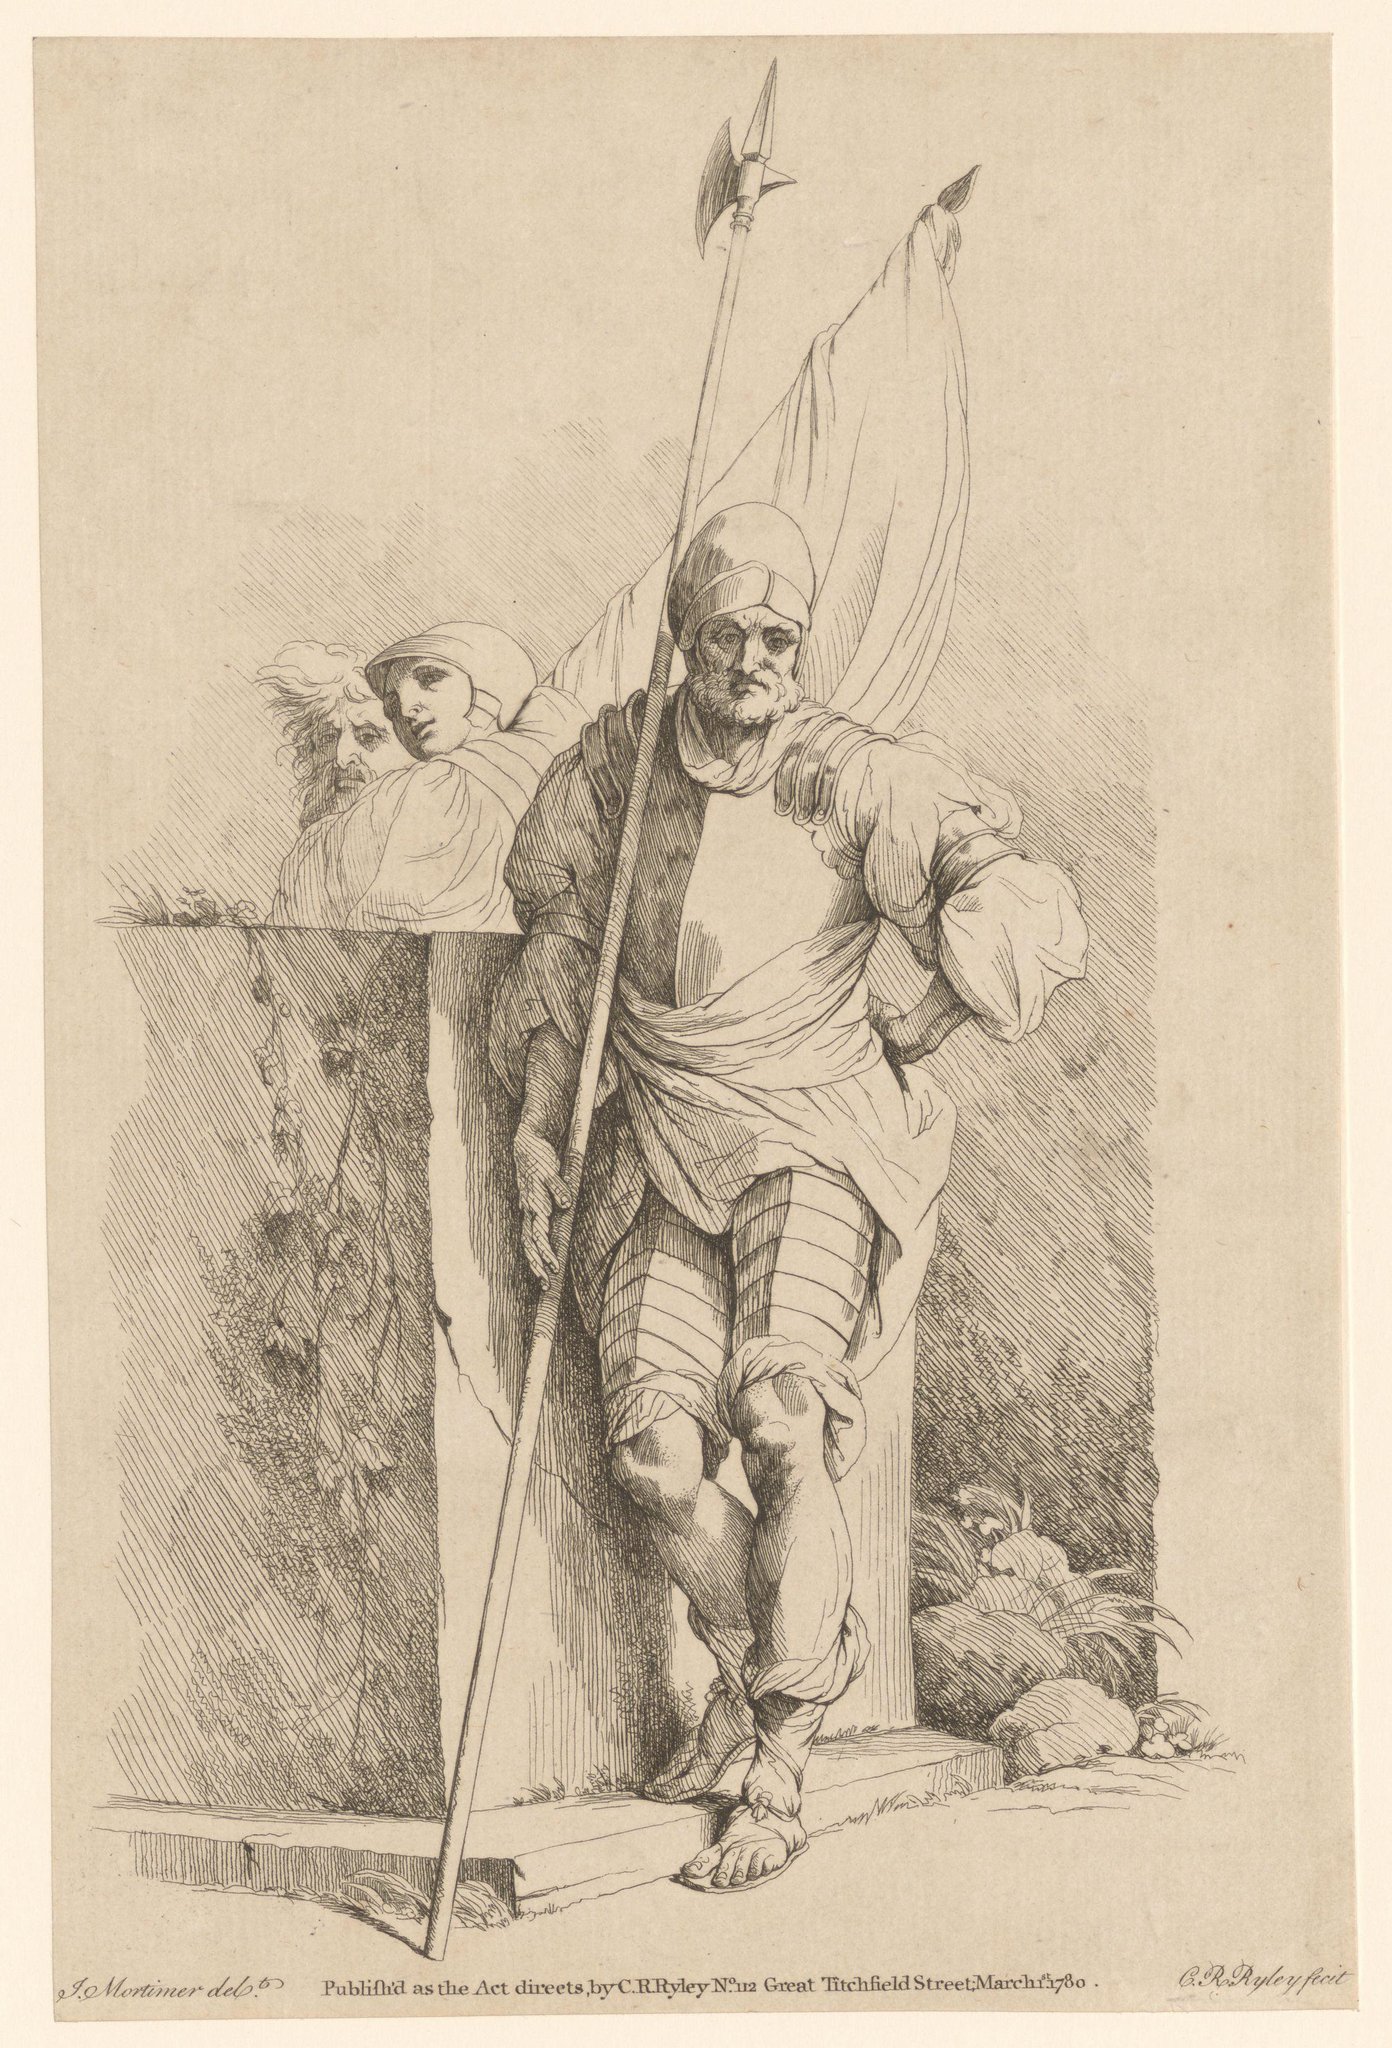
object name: print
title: Krijgsman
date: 1780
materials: paper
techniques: etching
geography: london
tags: private soldier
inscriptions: collector's mark: Lugt 2228